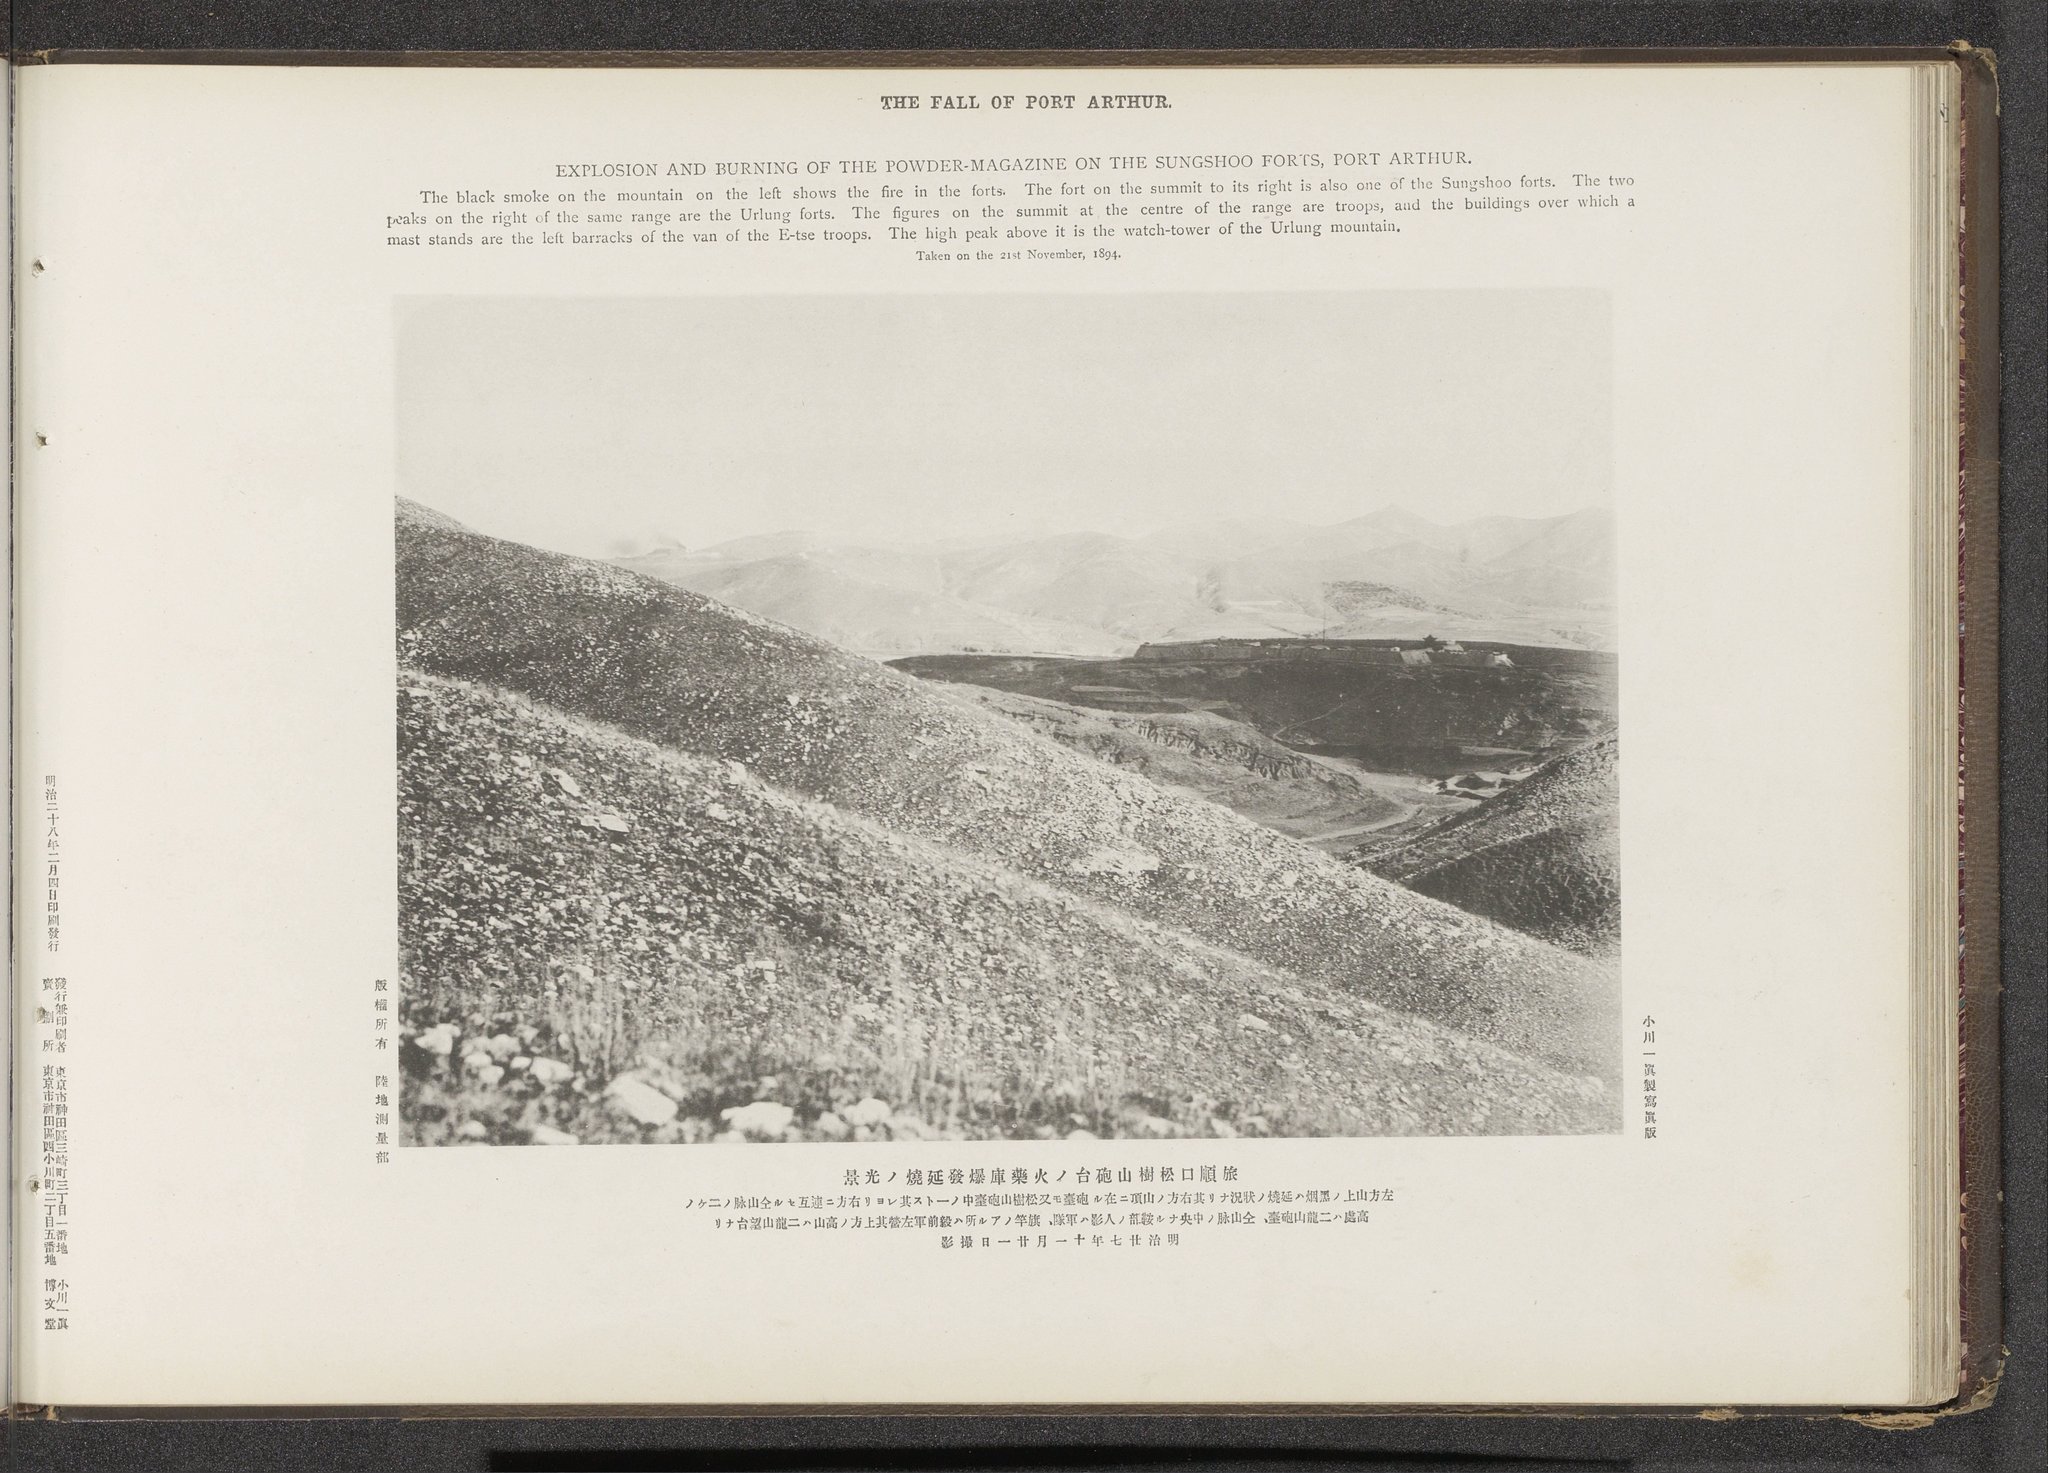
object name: page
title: Explosion and burning of the powder-magazine on the Sungshoo forts, Port Arthur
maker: kazumasa ogawa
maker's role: auteur, fotograaf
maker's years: 1860-1929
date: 1894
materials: paper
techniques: photograph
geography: manchuria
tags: projectiles, explosives, etc.: gunpowder, gunpowder disaster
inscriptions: inscription: ‘The fall of Port Arthur.’